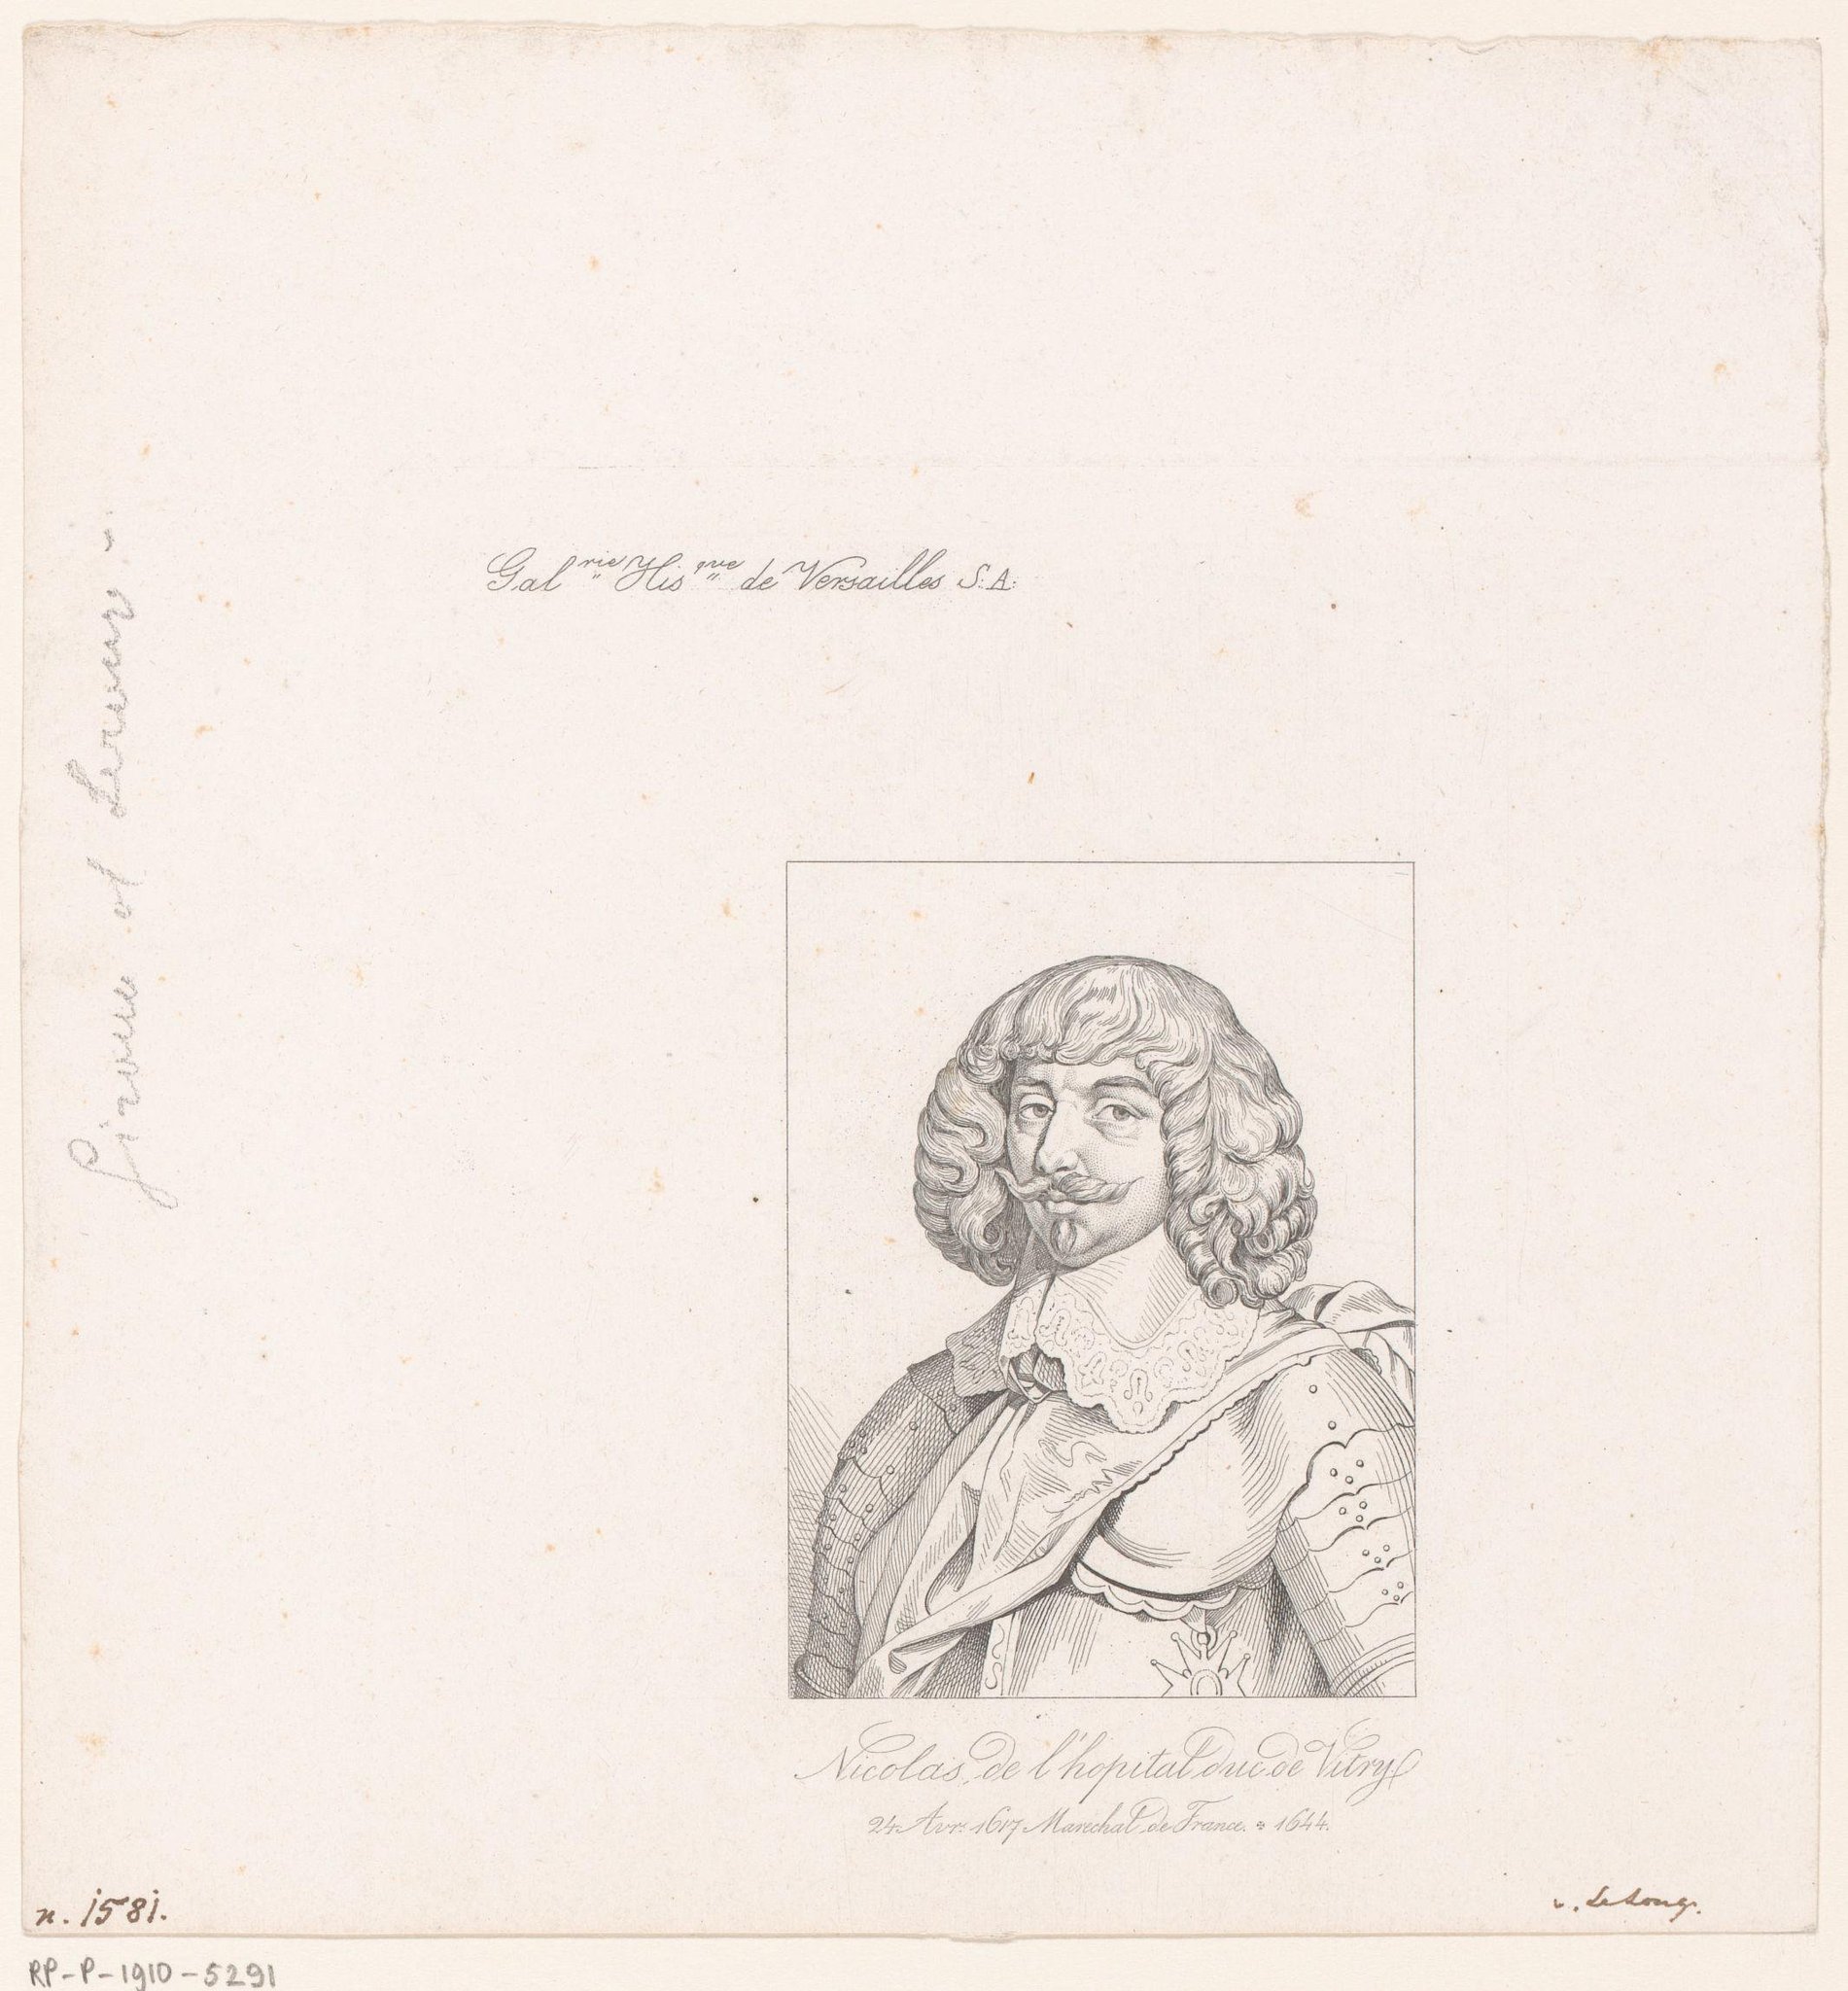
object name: book illustration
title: Portret van Nicolas de L'Hospital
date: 1838-1841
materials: paper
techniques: etching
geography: paris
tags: ranks in the army, historical persons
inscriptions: collector's mark: Lugt 2228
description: Prent uit: Galeries historiques de Versailles. Parijs: Charles Gavard, 1838-1841.